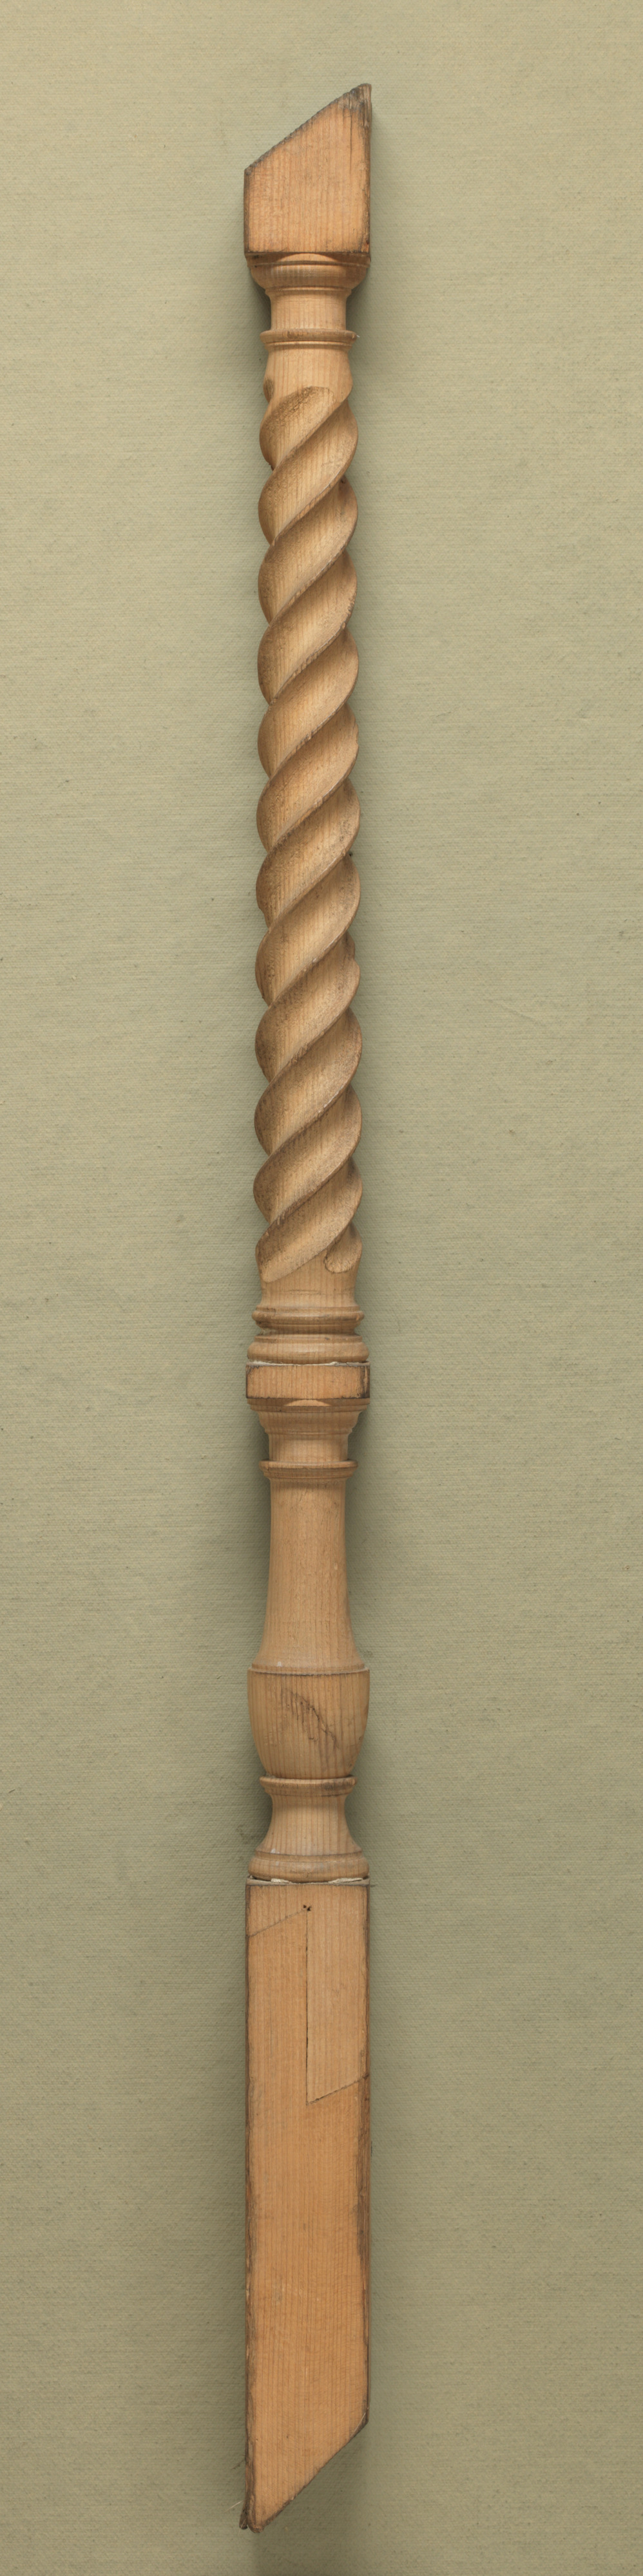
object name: baluster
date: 1734-1766